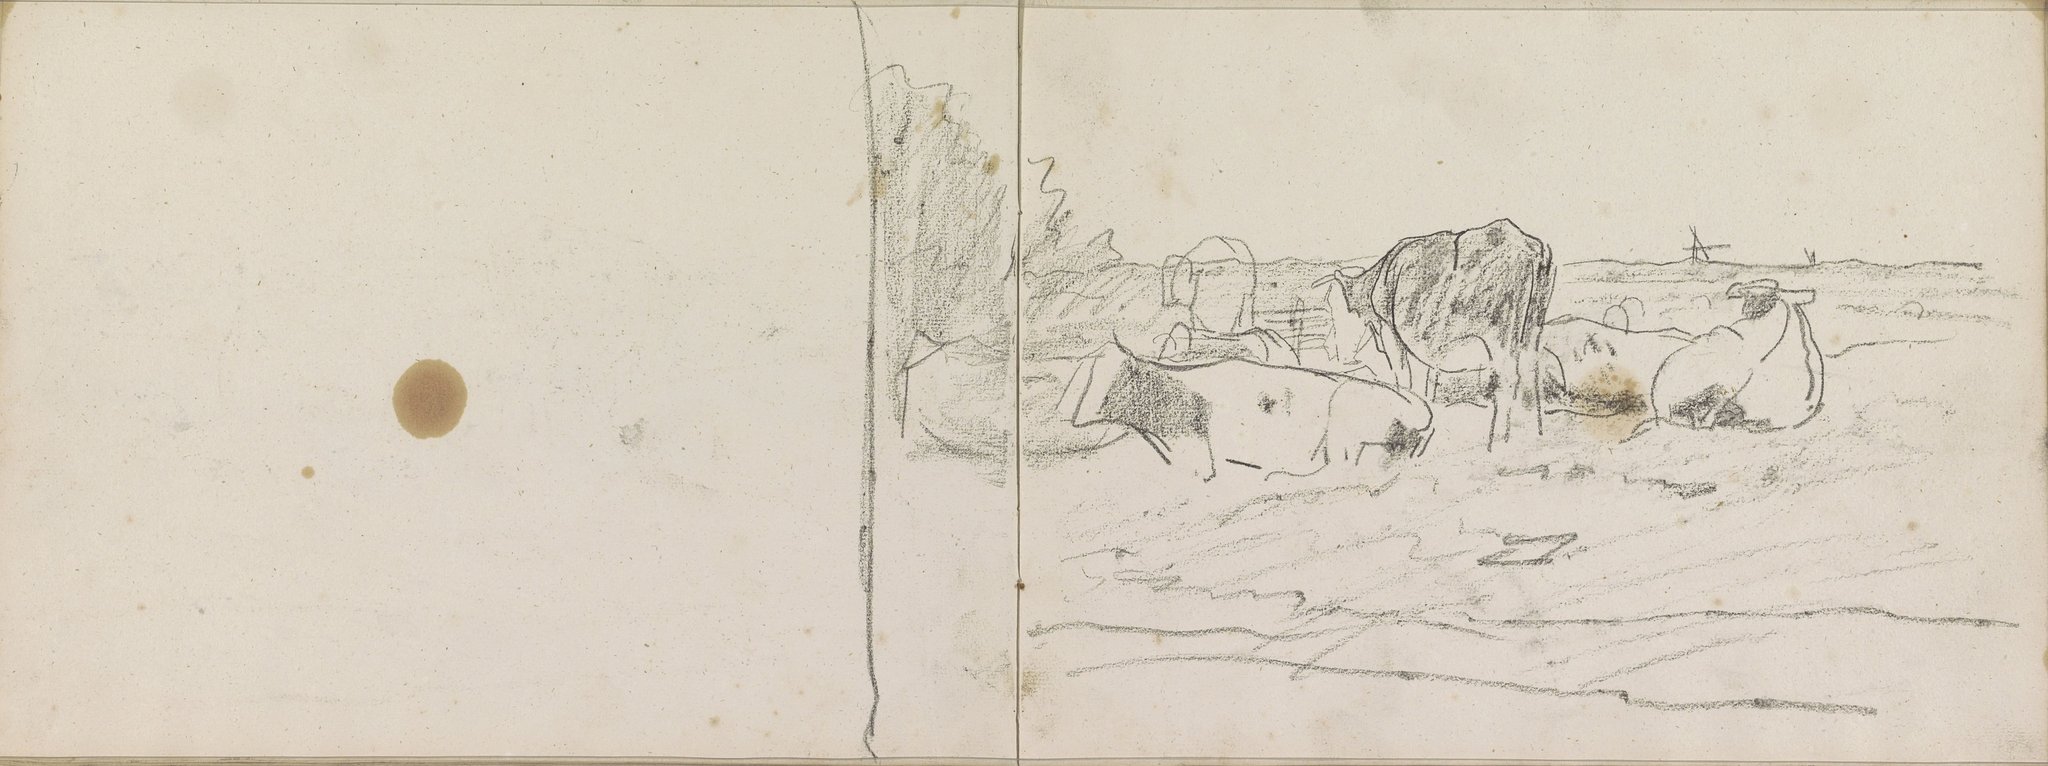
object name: sketchbook leaf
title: Staande en liggende koeien in een weide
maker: anton mauve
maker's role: draughtsman, painter, print maker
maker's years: 1838-1888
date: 1848-1888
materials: chalk, paper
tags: cow, meadow, pasture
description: Op de achtergrond een molen aan de horizon. Blad 21 verso en 22 recto uit een schetsboek met 34 bladen.